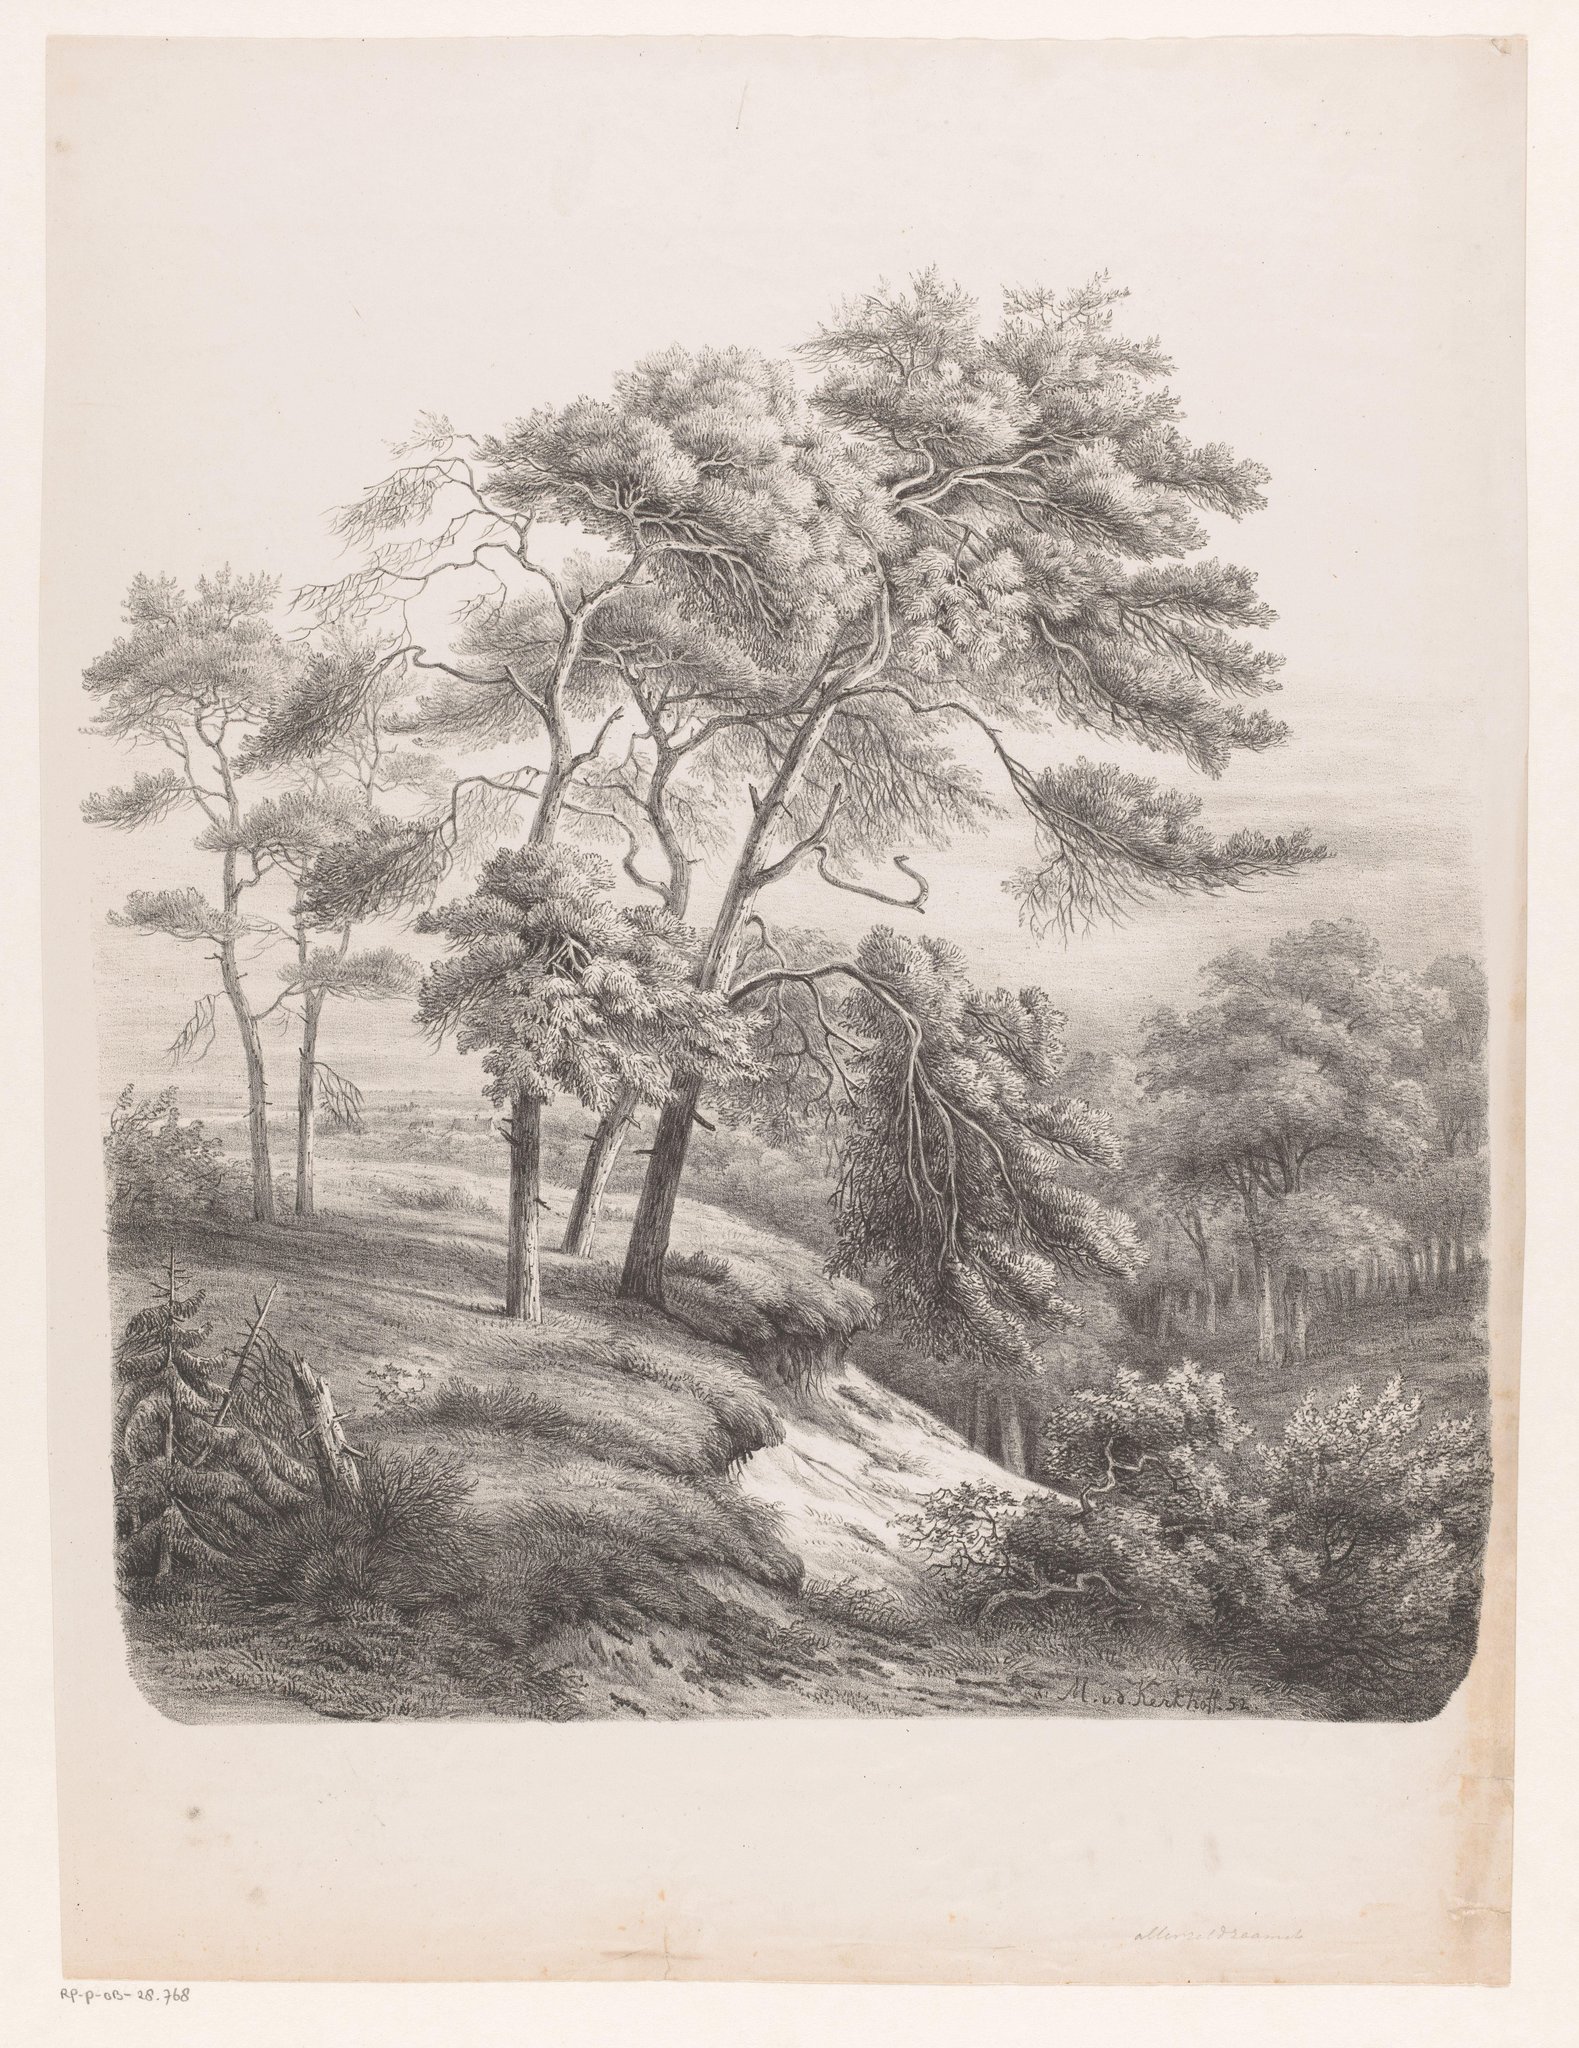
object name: print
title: Groep bomen in een heuvelachtig landschap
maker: maurits e.h.r. van den kerkhoff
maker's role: painter, print maker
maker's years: 1830-1908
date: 1852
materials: paper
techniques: lithograph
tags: low hill country, groups of trees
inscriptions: collector's mark: Lugt 2228, inscription: ‘allerzeldzaamst’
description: In de achtergrond, achter de bomen, een huis.